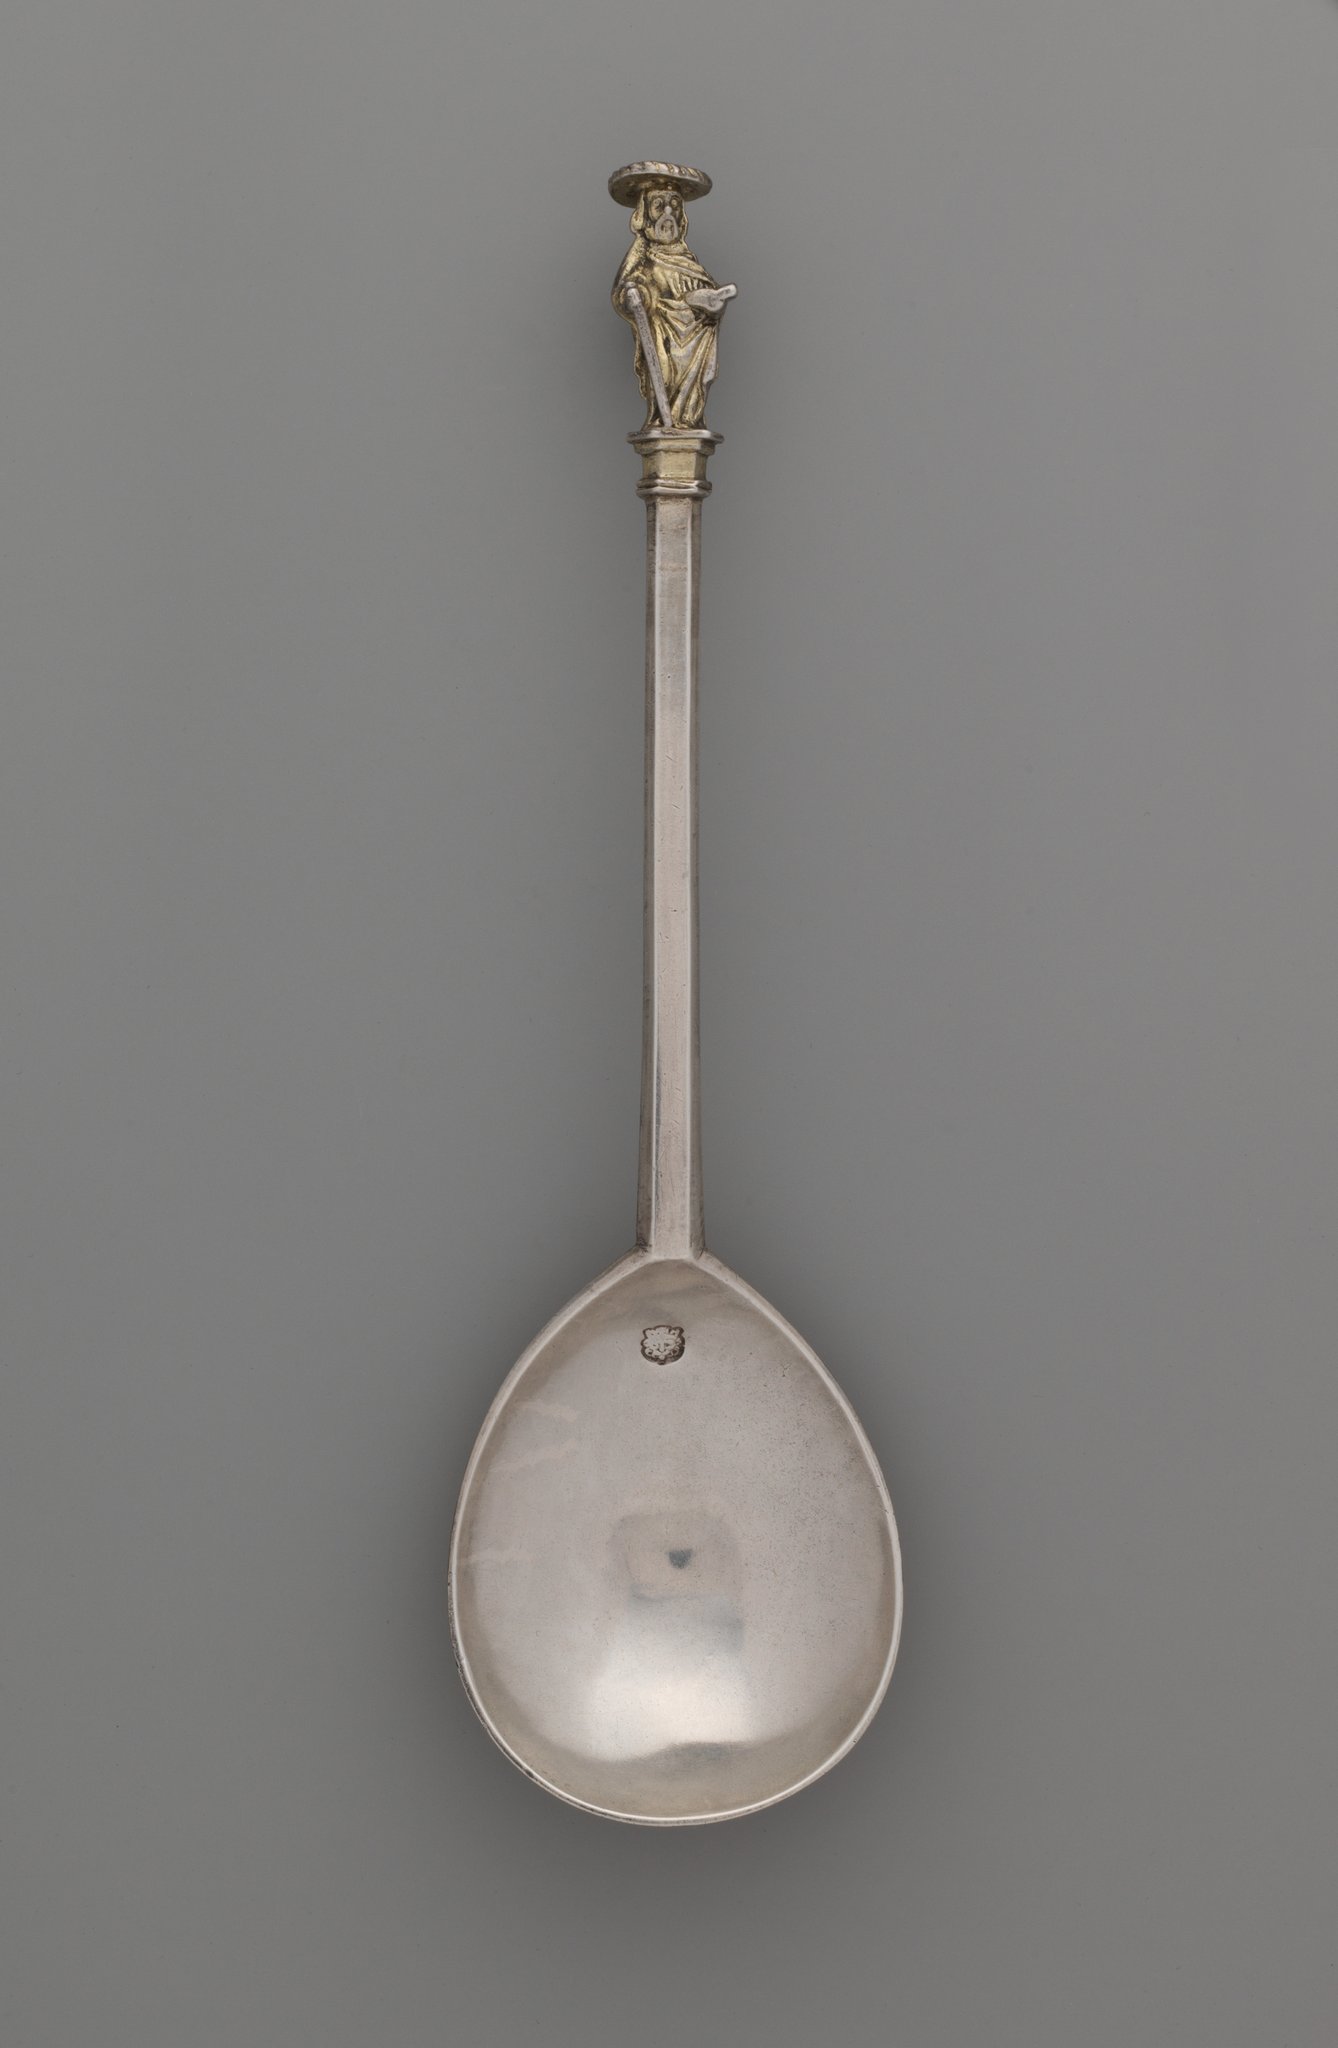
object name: apostle spoon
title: Apostle spoon: St. Philip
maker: william cawdell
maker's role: maker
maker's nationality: british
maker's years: 1560-1625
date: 1592-1593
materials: silver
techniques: gilding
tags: apostles